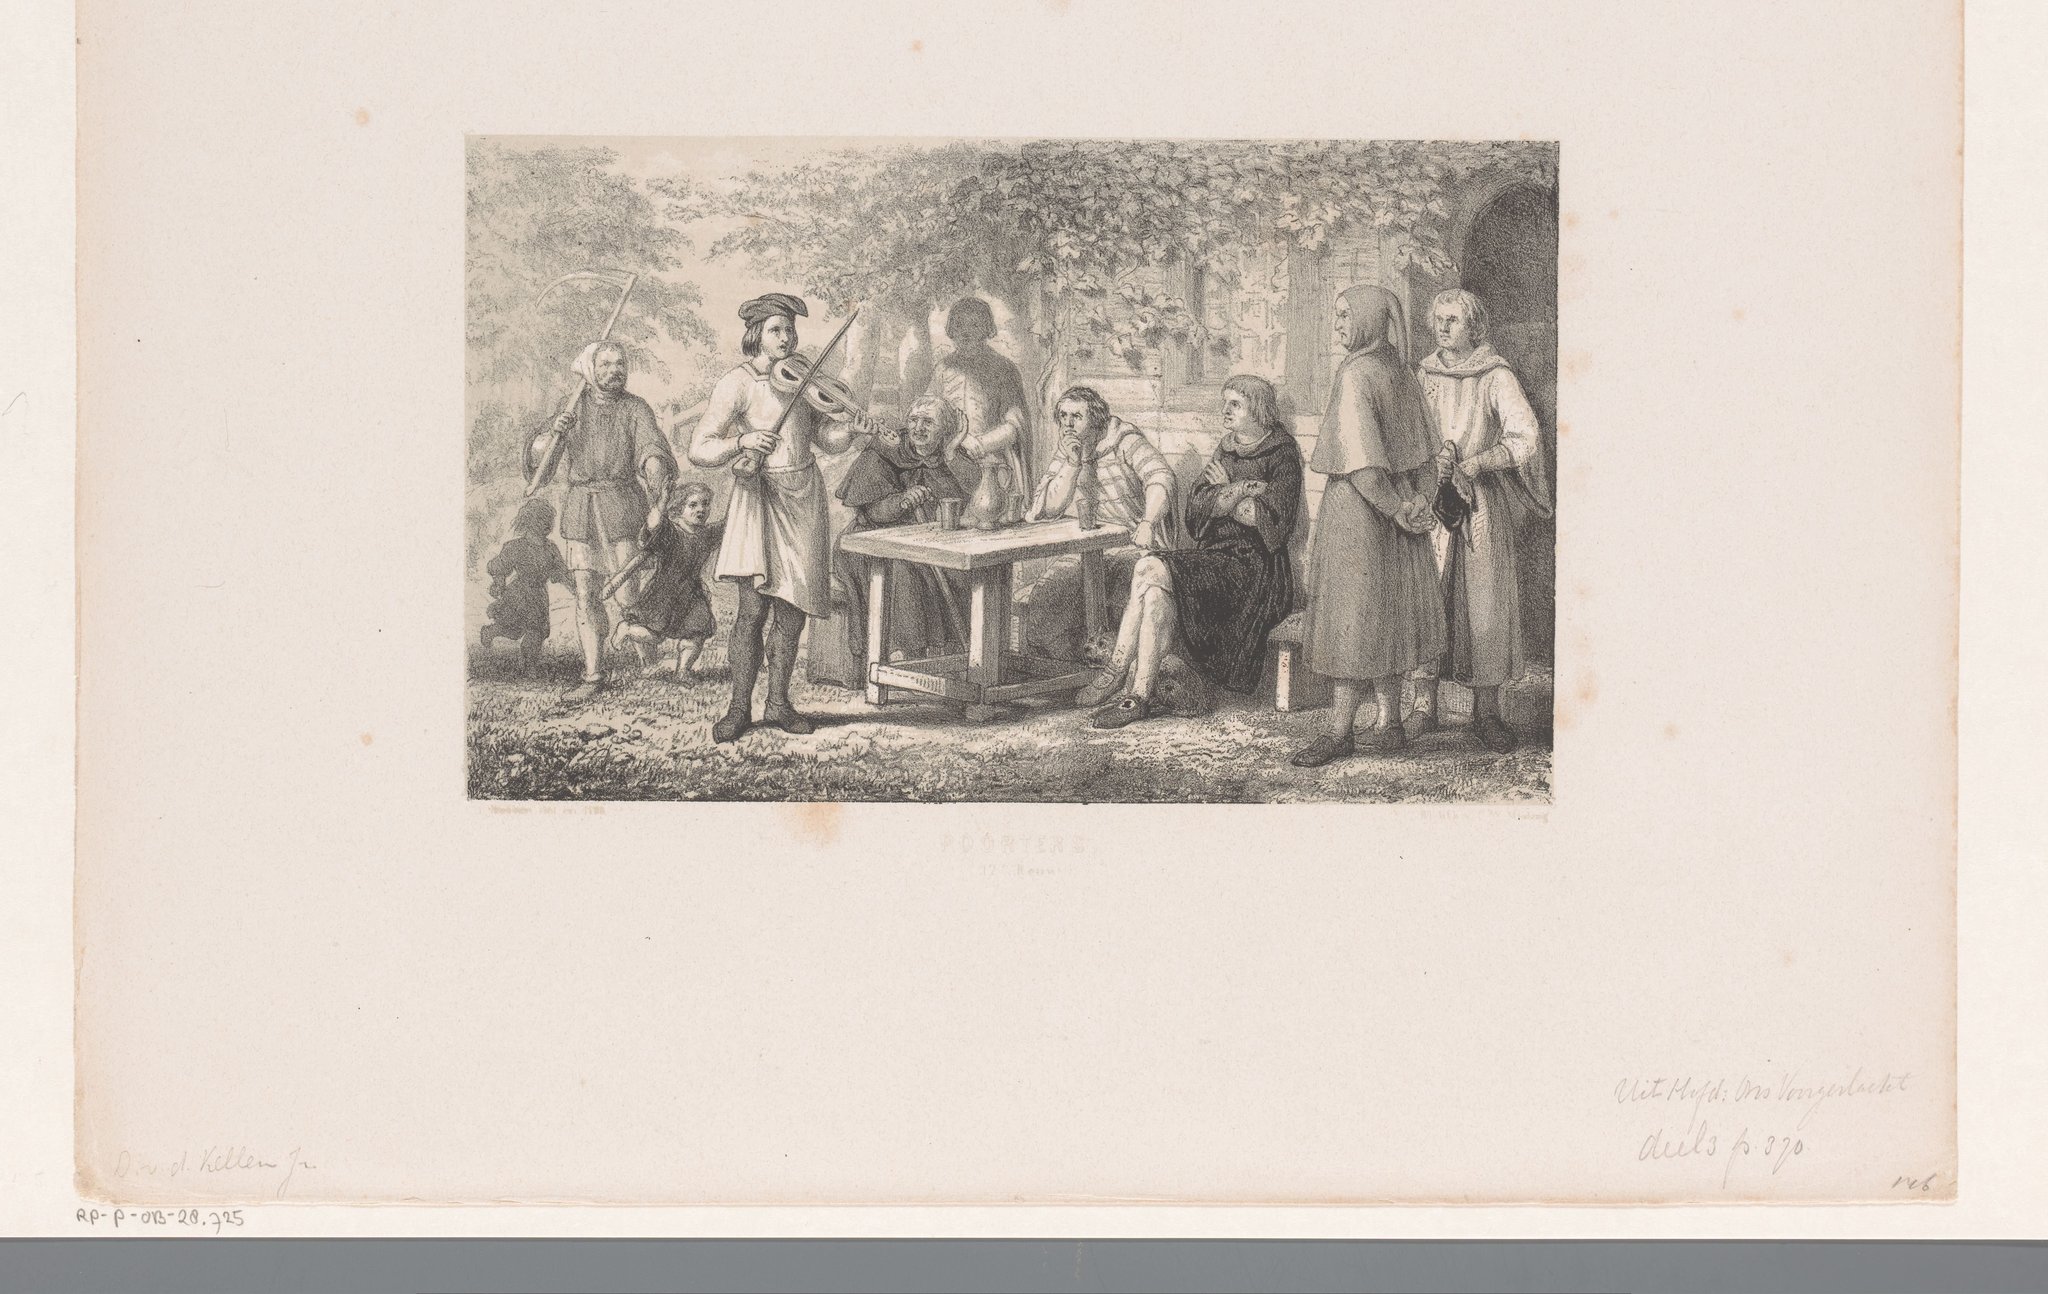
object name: print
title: Herberg met gasten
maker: david van der kellen (1827-1895)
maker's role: draughtsman, print maker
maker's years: 1827-1895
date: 1857-1864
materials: paper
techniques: tone lithography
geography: the hague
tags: pavement, terrace in front of inn or restaurant, instrumental popular music, netherlands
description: Illustratie voor: W.J. Hofdijk, Ons voorgeslacht in zijn dagelyksch leven geschilderd, Kruseman, Haarlem 1859-1864, dl. 3, p. 370.